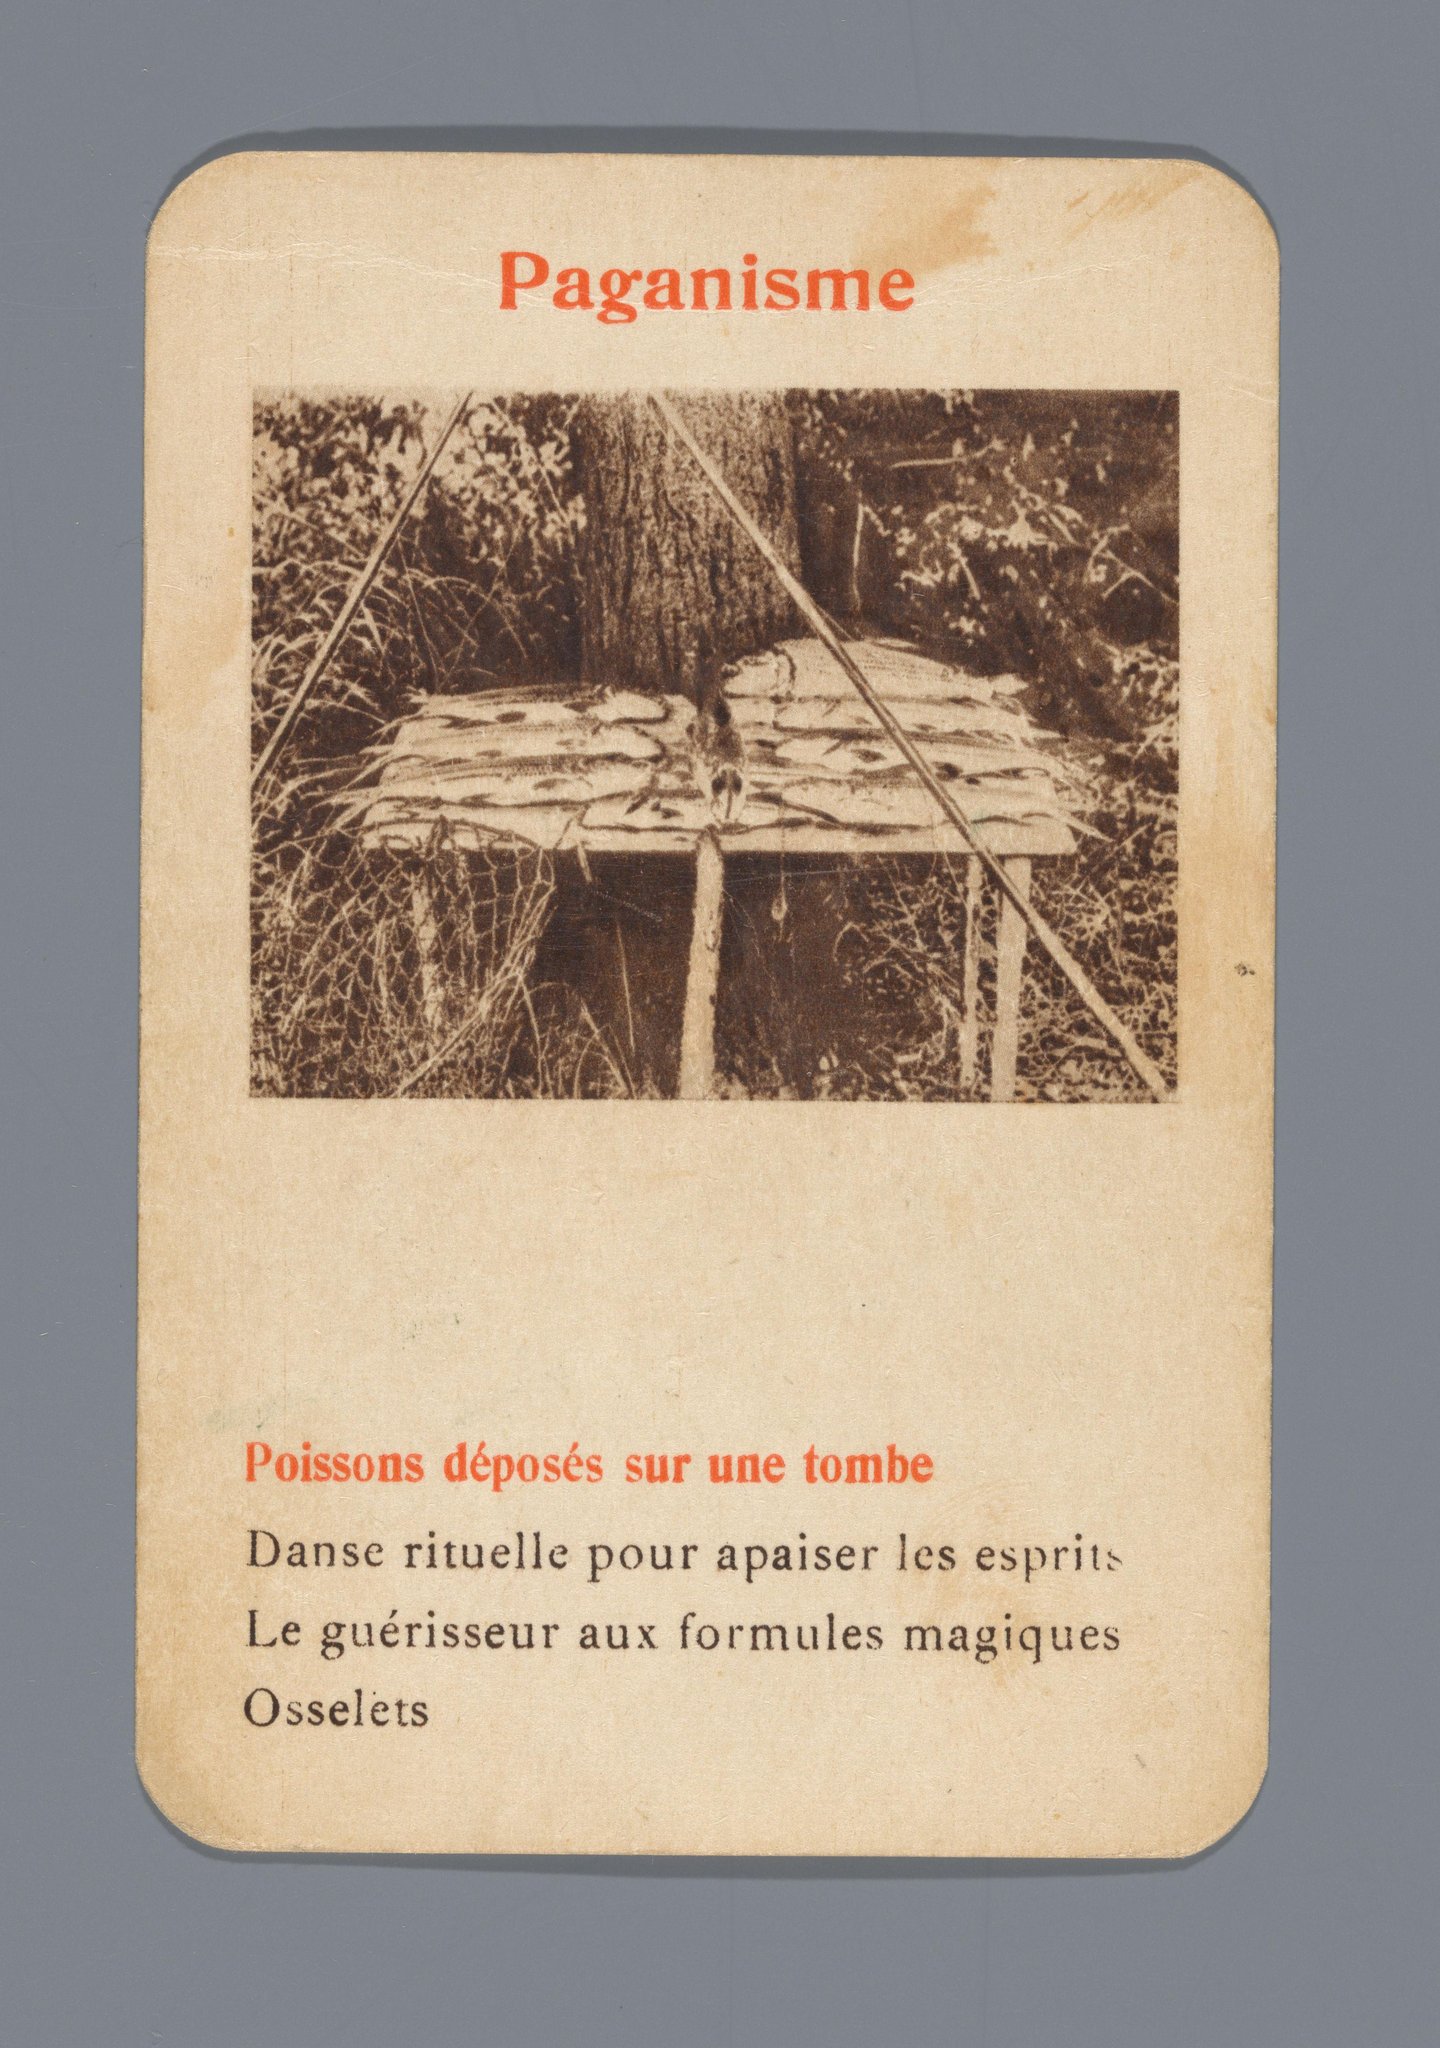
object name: photomechanical print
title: Paganisme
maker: Anonymous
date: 1900-1920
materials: cardboard, paper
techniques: rotogravure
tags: african traditional religions, card games